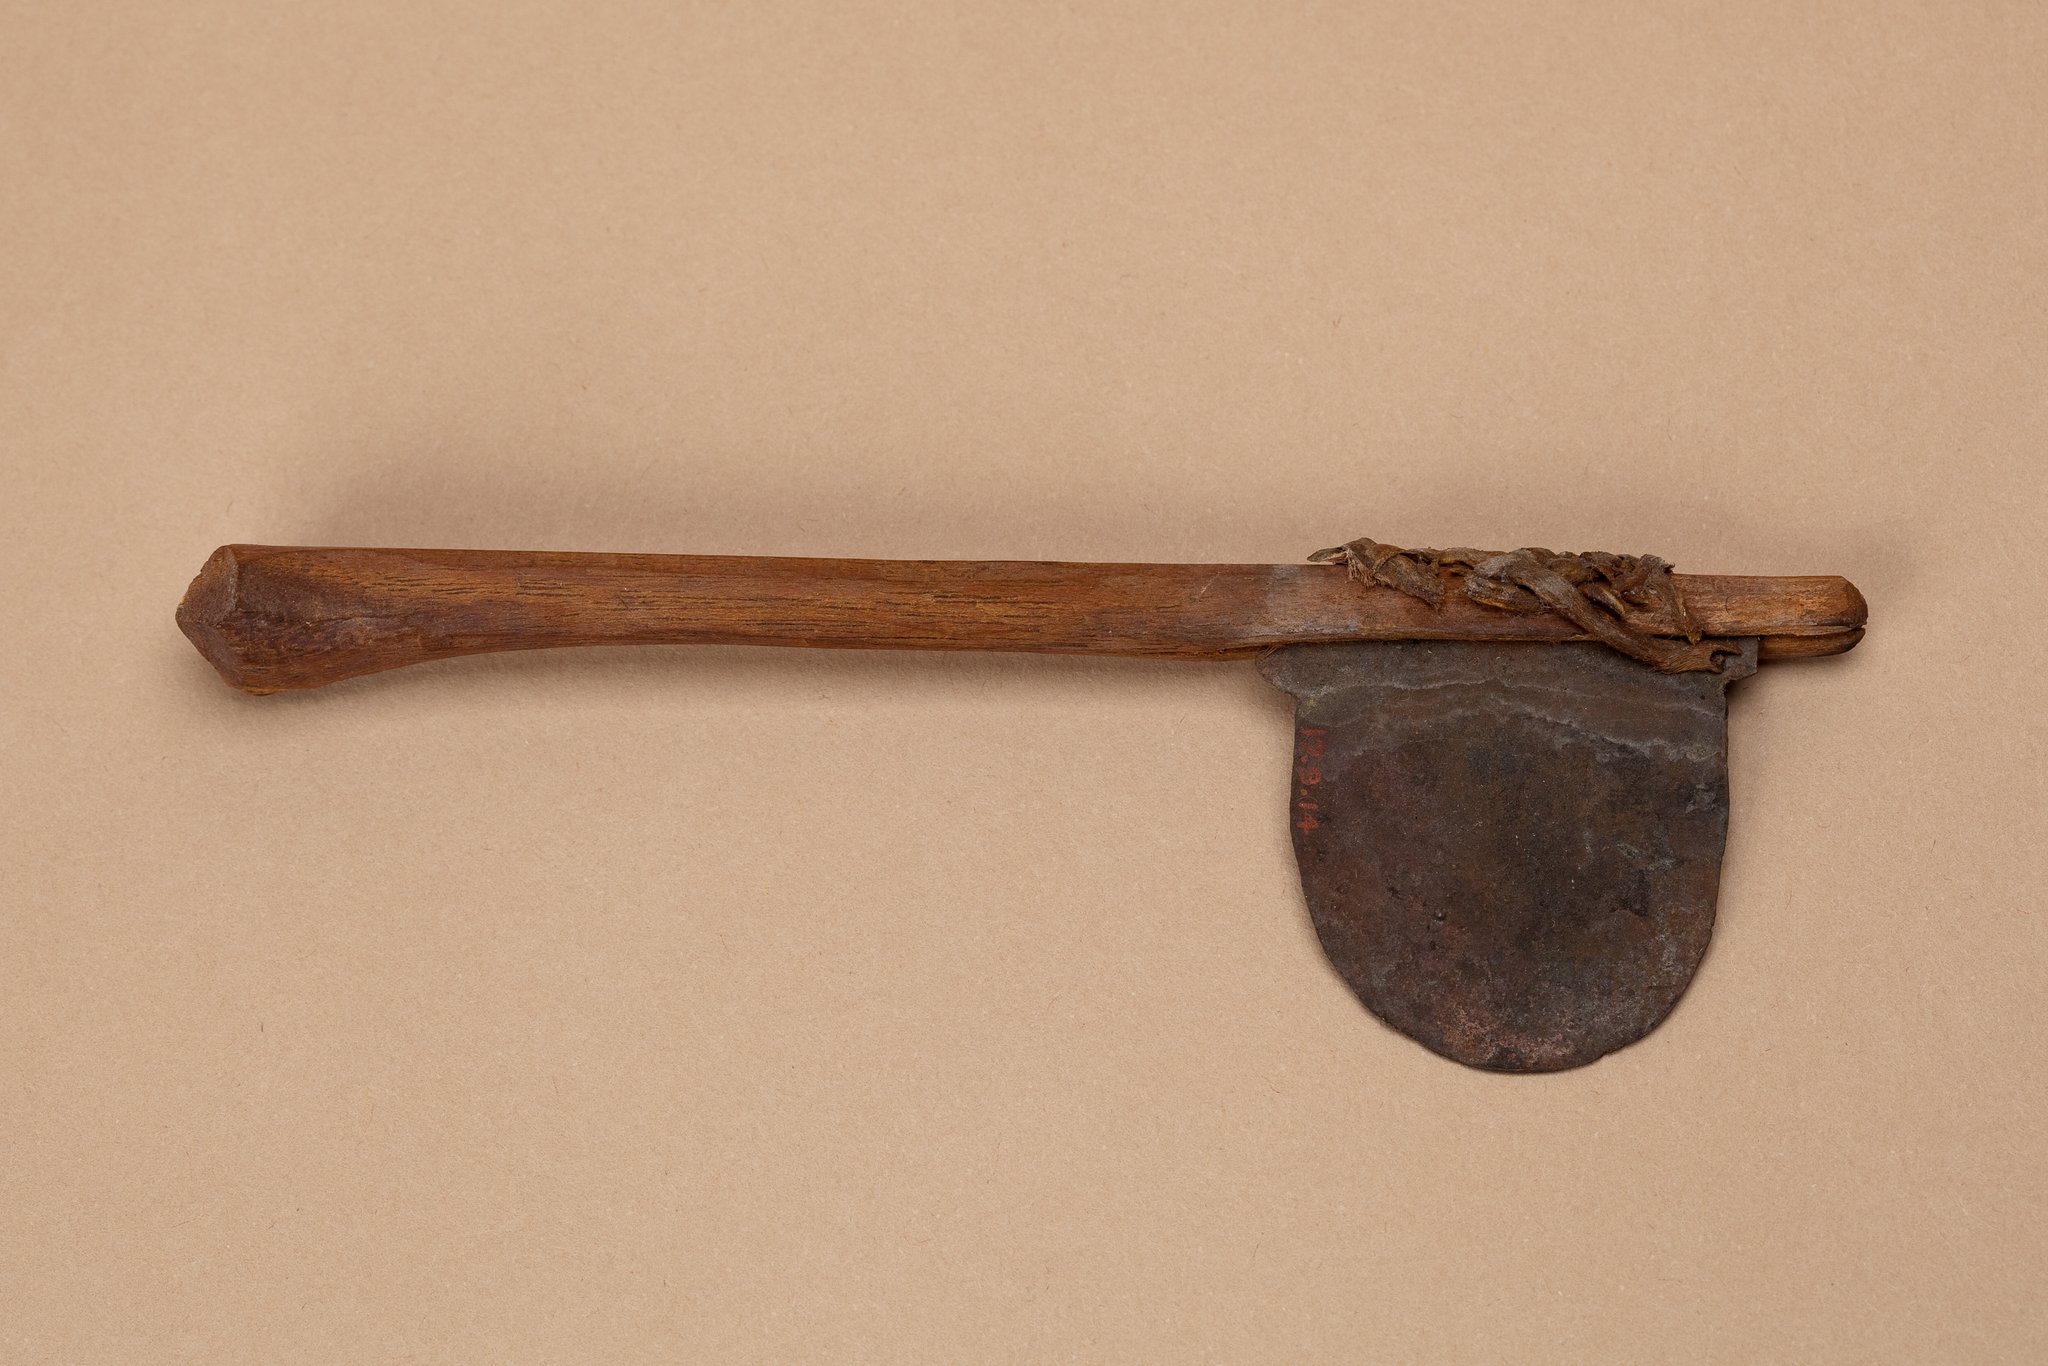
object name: model ax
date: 1981-1802 BCE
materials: copper, wood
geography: egypt